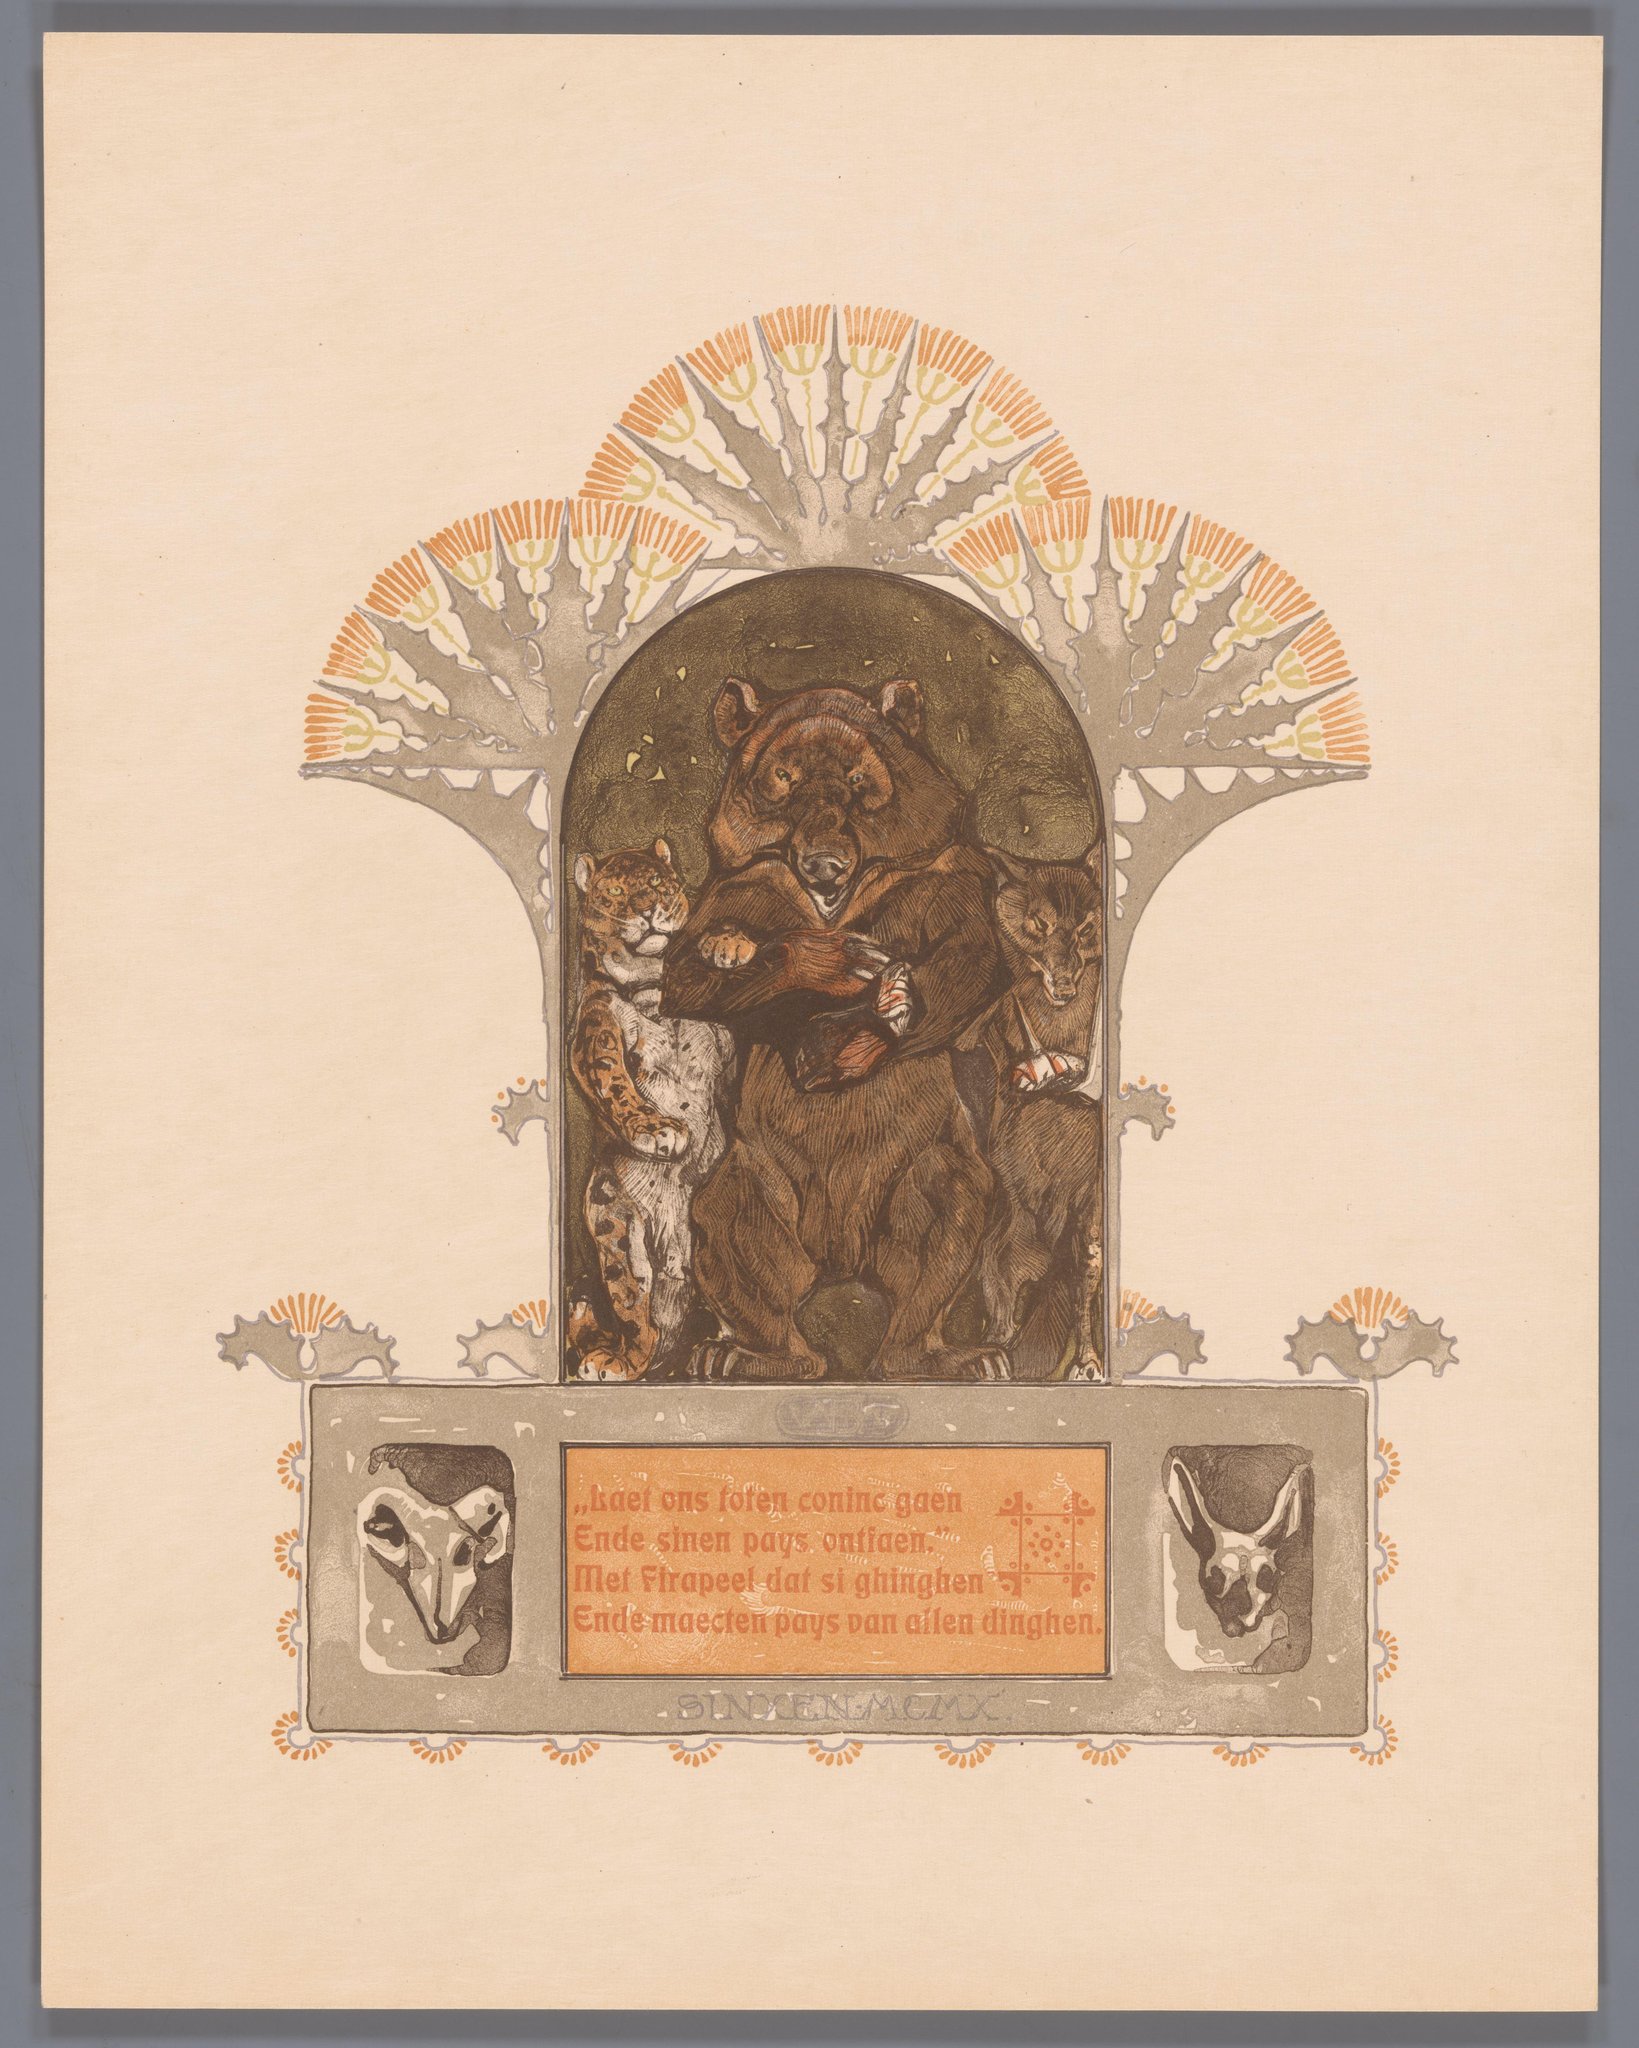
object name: print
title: Luipaard, beer en wolf (Firapeel, Bruun en Isegrim)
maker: bernard willem wierink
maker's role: draughtsman, print maker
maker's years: 1856-1939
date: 1910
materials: paper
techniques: lithograph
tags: fable of reynard the fox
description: Prent gebruikt in: Streuvels, Stijn (Frank Lateur). Reinaert de Vos naar verschillende uitgaven van het middeleeuwsche epos. Amsterdam: L.J. Veen, 1910.